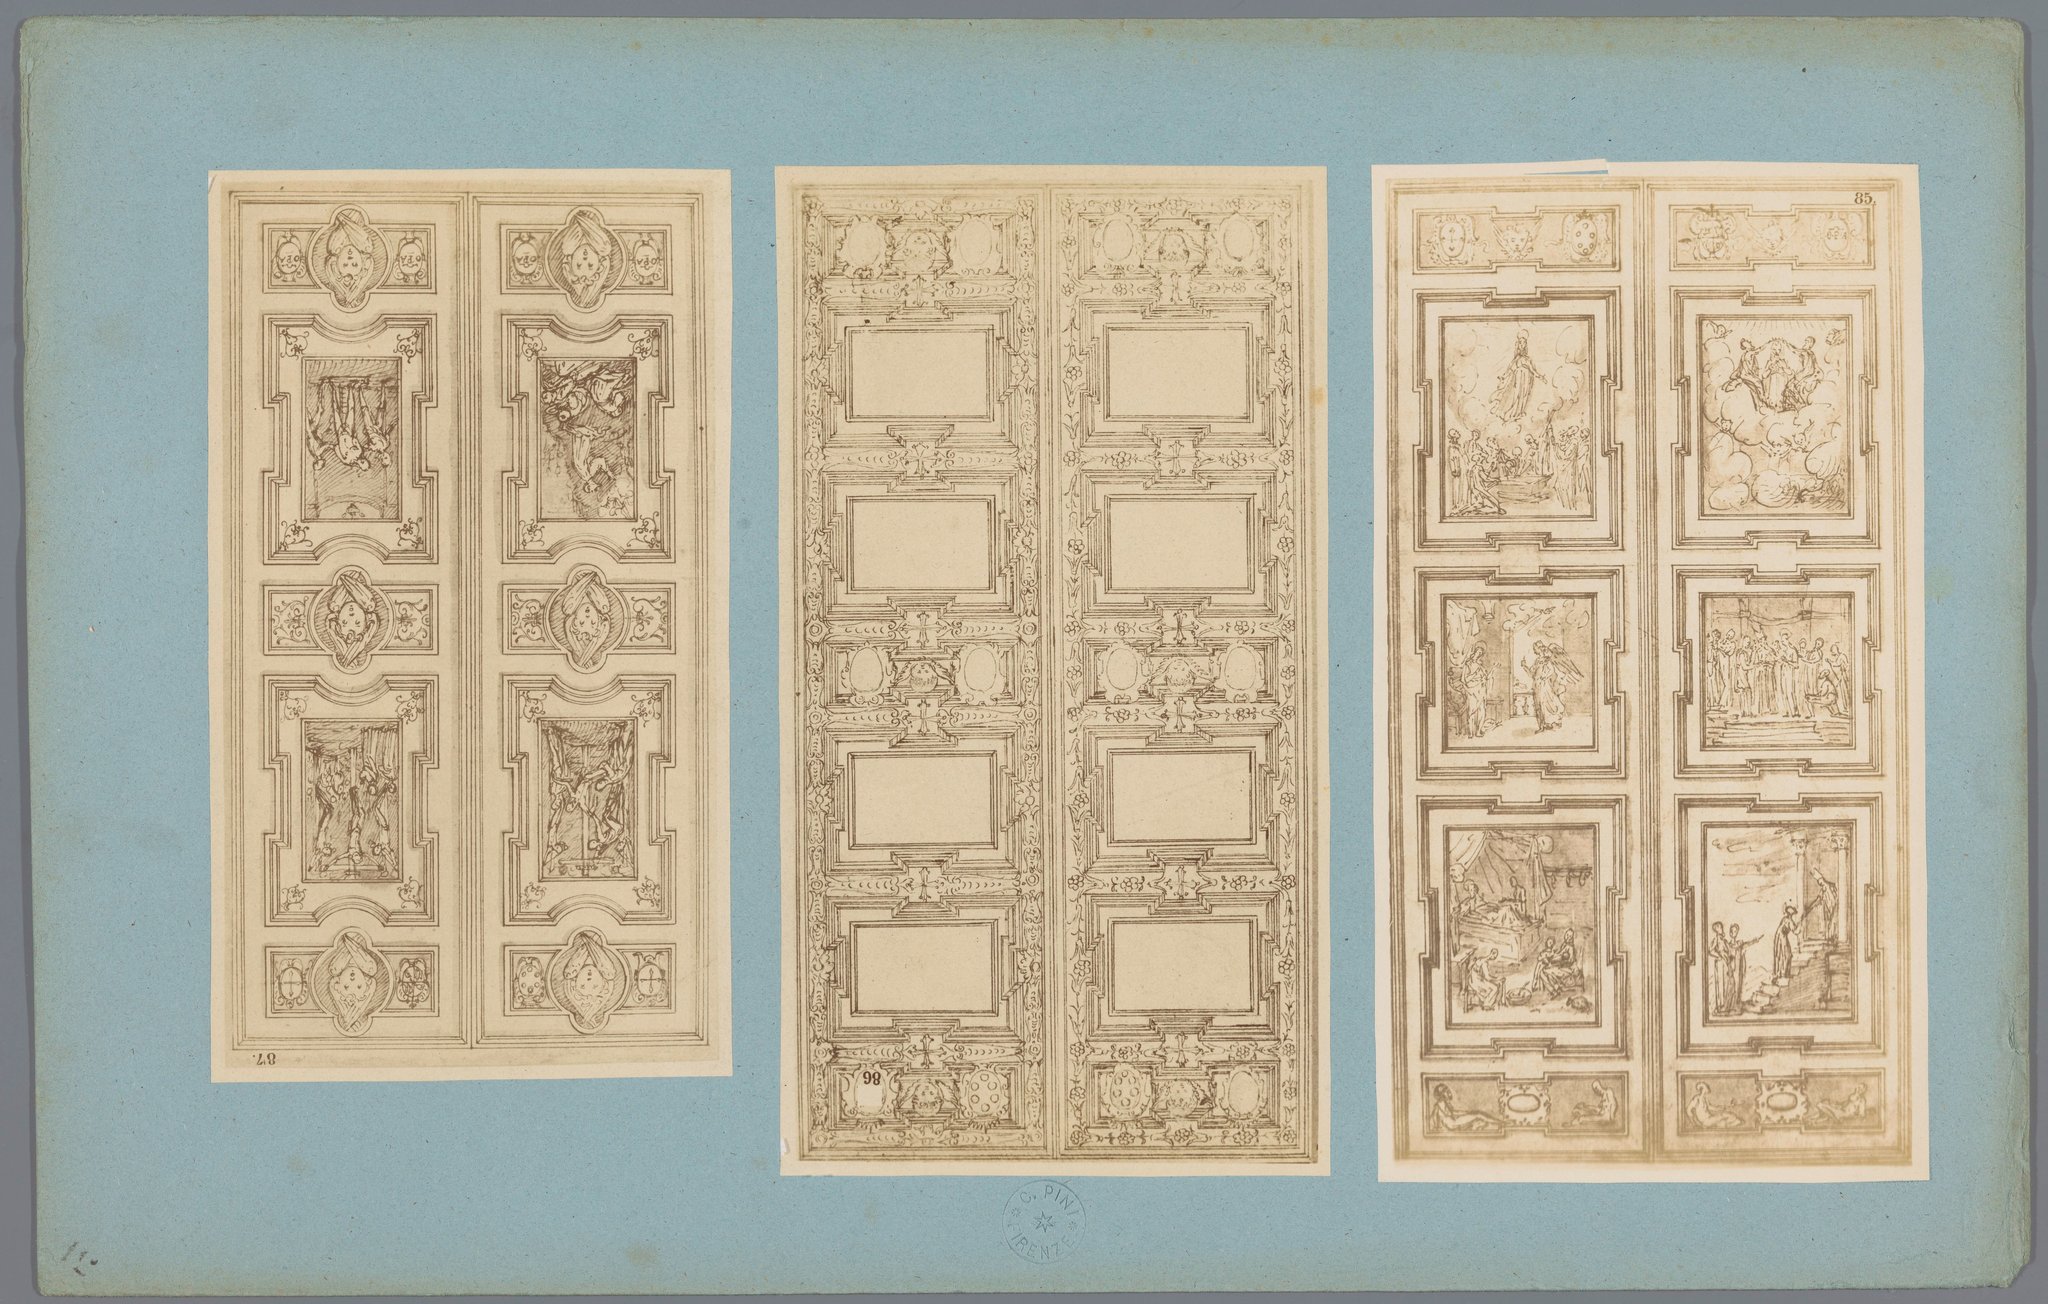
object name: photograph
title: Drie fotoreproducties van tekeningen van decoratieve vlakvullingen, vermoedelijk deuren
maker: Anonymous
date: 1875-1900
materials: cardboard, photographic support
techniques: albumen print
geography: europe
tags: drawing, sketch, christ, door, cupids: 'amores', 'amoretti', 'putti', europe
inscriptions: number: ‘85.’, number: ‘31’, number: ‘86’, number: ‘87.’, collector's mark: Lugt 3937, name: ‘C. Pini Firenze’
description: Links (87) panelen met voorstellingen van de kruisiging van Christus, midden (86) panelen gedecoreerd met plantmotieven en engelen, rechts (85) panelen met Bijbelse voorstellingen.